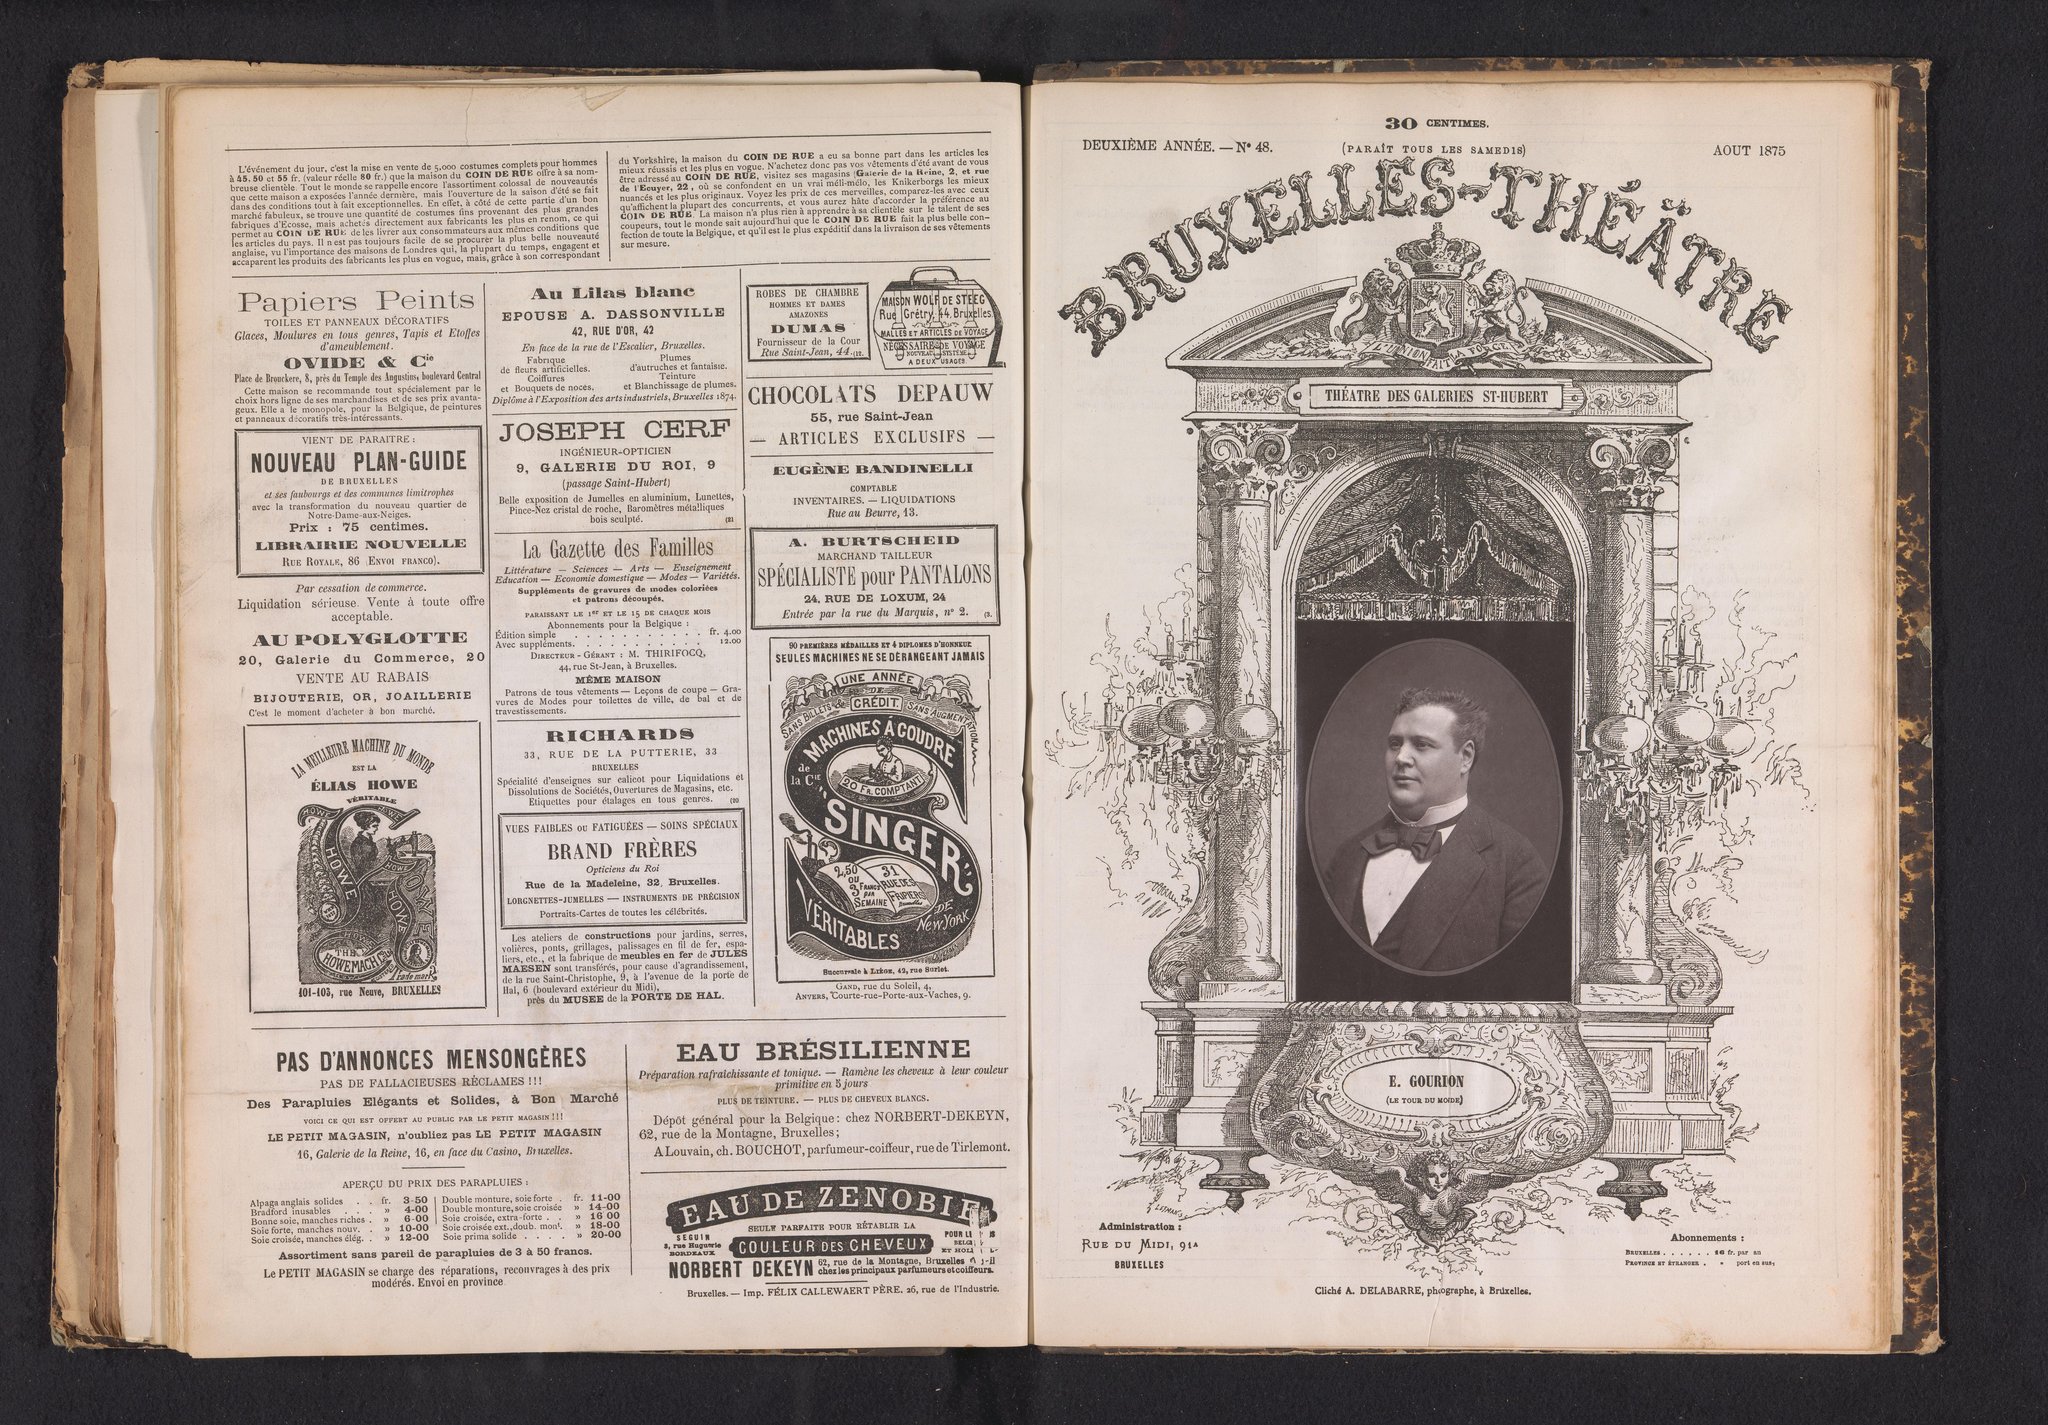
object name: photomechanical print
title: Portret van E. Gourdon in Le tour du monde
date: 1870-1875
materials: paper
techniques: woodburytype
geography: brussels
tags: portrait of actor, actress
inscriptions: number: ‘No 48.’